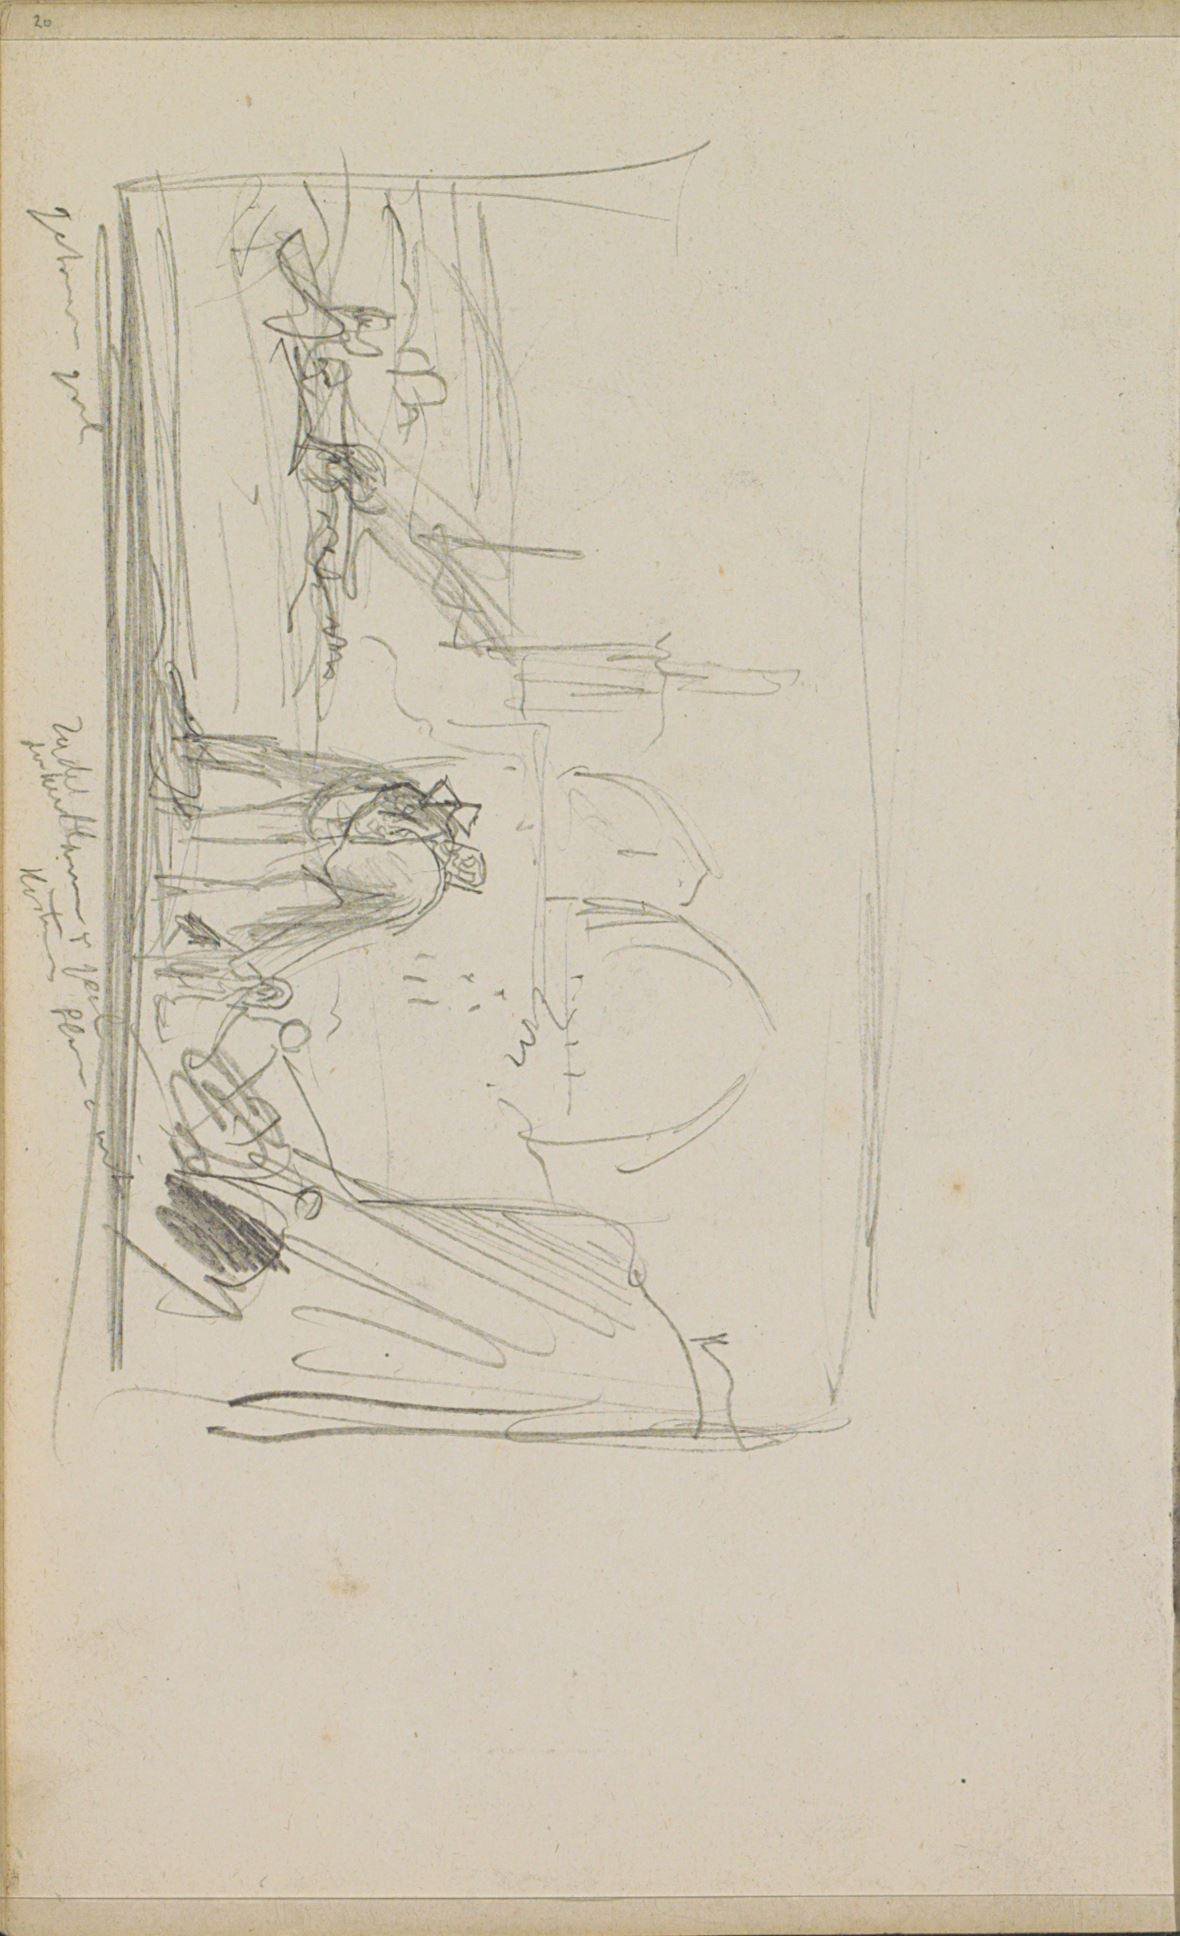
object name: sketchbook leaf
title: Zittende figuren en een kameel bij de Citadel van Caïro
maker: marius bauer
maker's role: draughtsman, print maker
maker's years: 1867-1932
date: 1904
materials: paper, pencil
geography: cairo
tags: hoofed animals: camel, sitting figure, fortifications, military engineering, dome ~ architecture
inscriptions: kleurnotitie, handgeschreven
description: Op de achtergrond zijn mogelijk de koepels van de moskee van Mamluk te zien. Pagina 20 uit een schetsboek met 56 bladen.